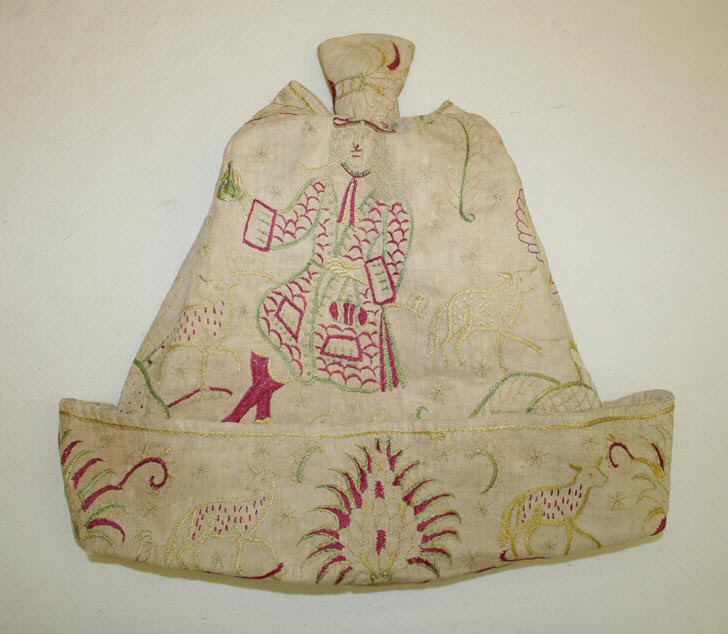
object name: cap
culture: british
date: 1601-1625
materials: linen, silk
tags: men,sheep